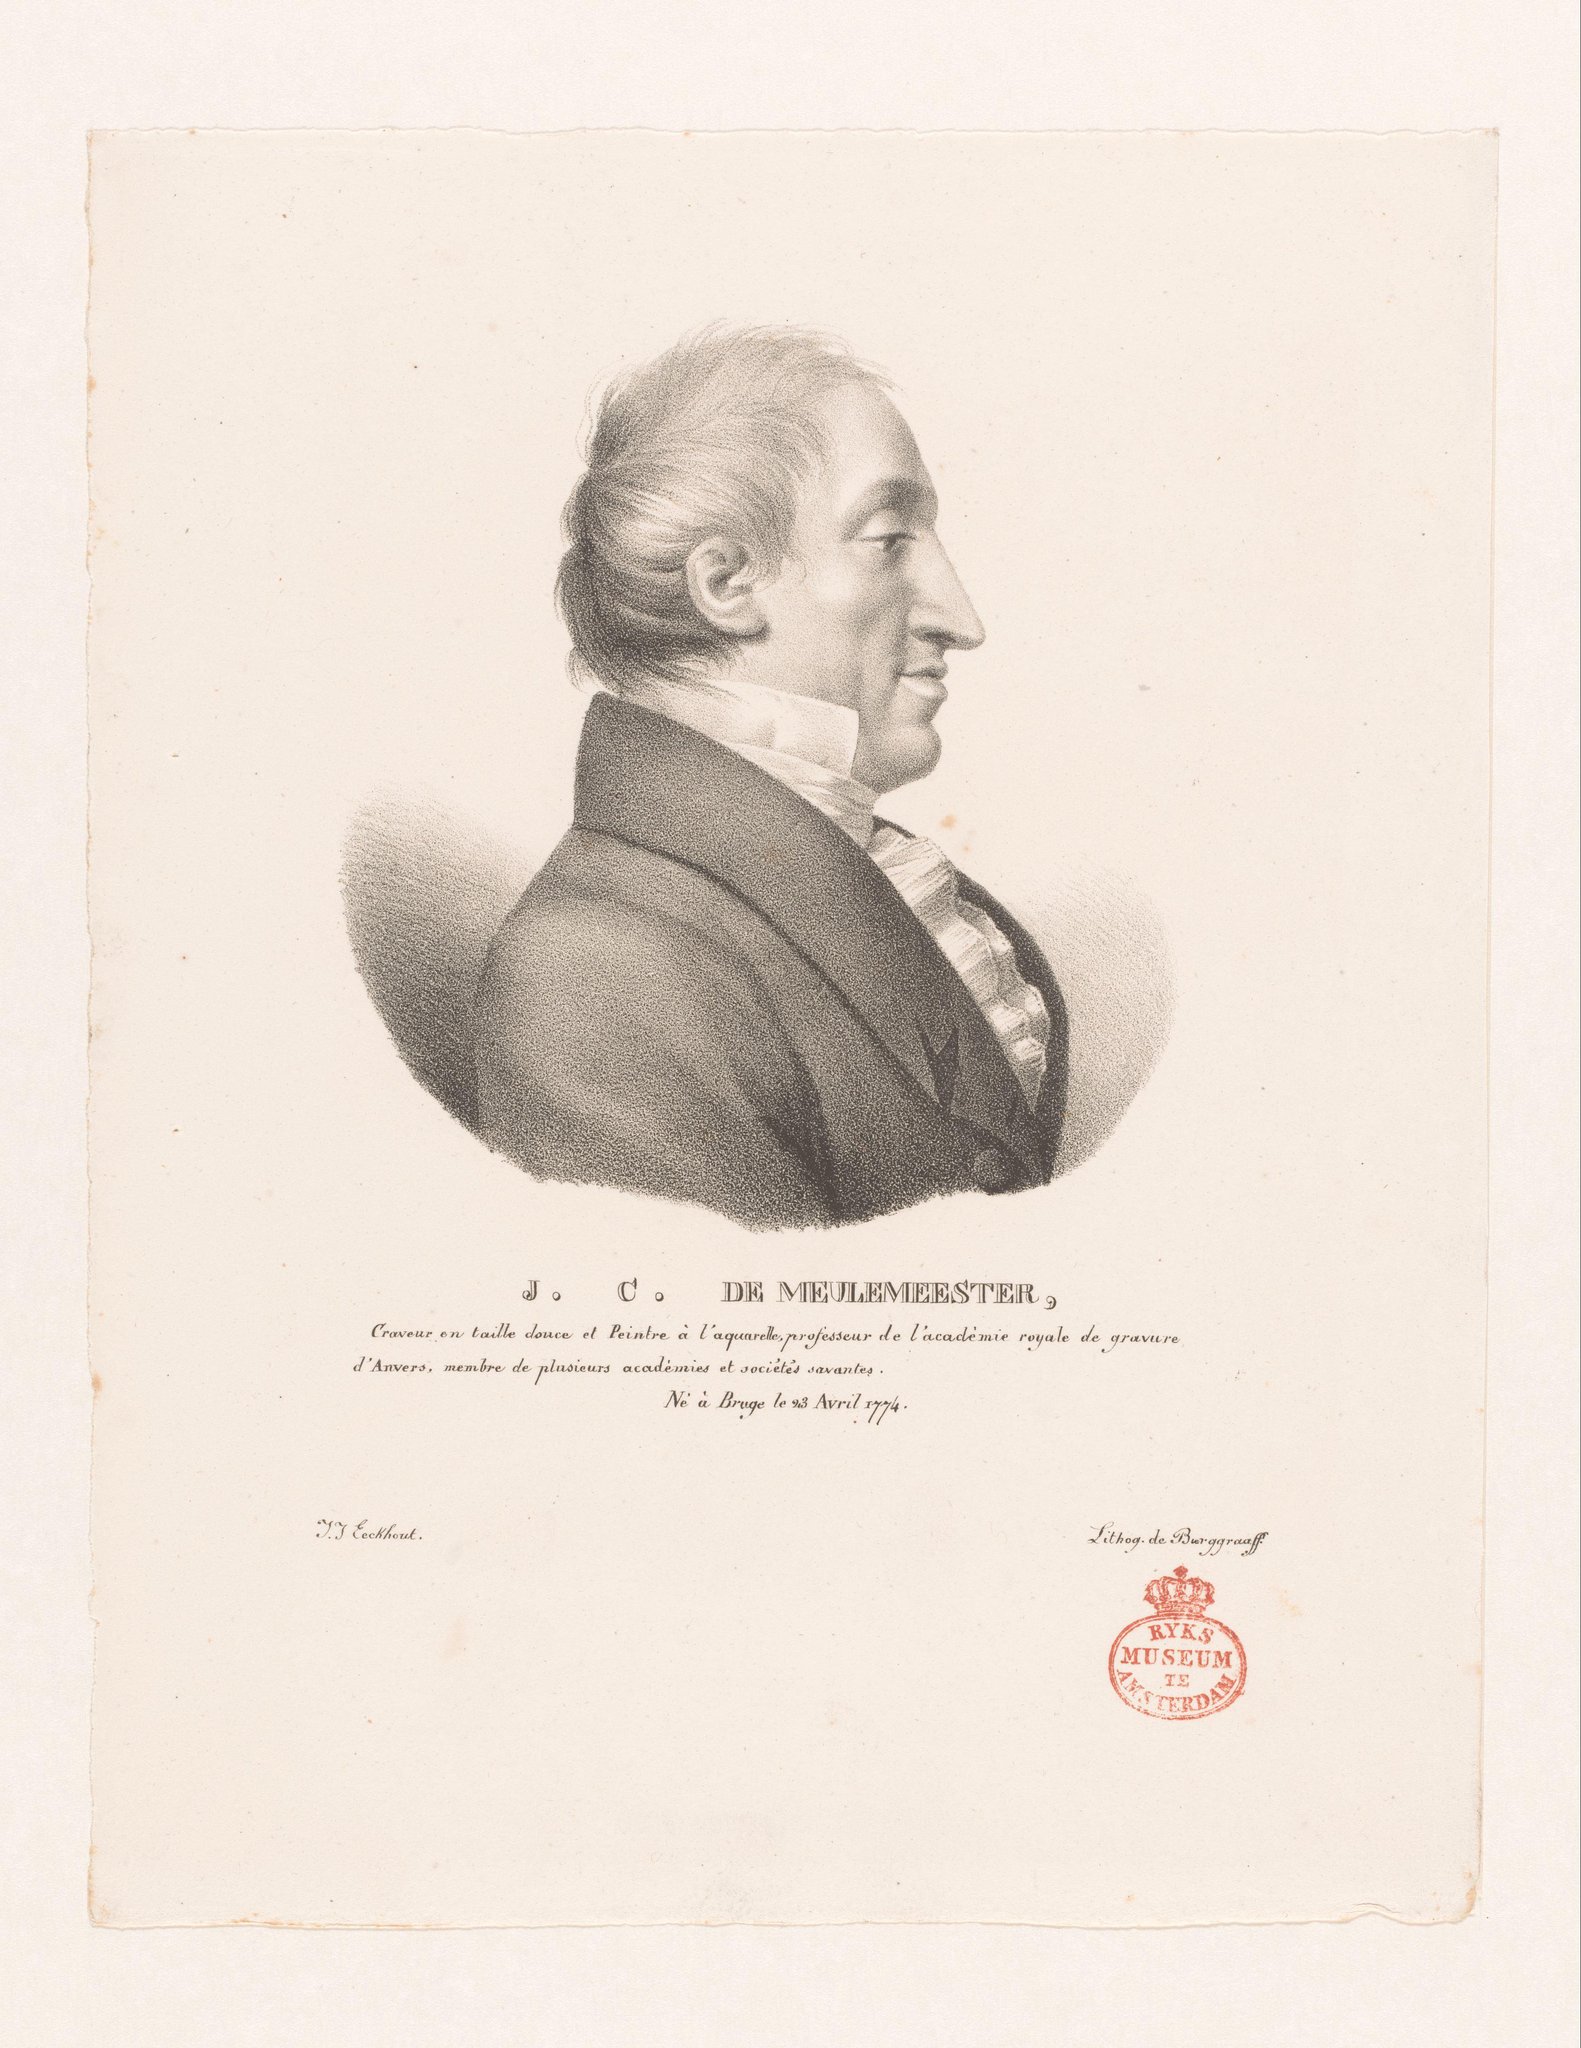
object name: print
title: Portret van Jozef Karel De Meulemeester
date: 1822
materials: paper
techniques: lithograph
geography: brussels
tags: print maker, jozef karel de meulemeester, historical persons, portrait, self-portrait of painter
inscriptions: collector's mark: Lugt 12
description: Prent maakt deel uit van een serie van zestig prenten.